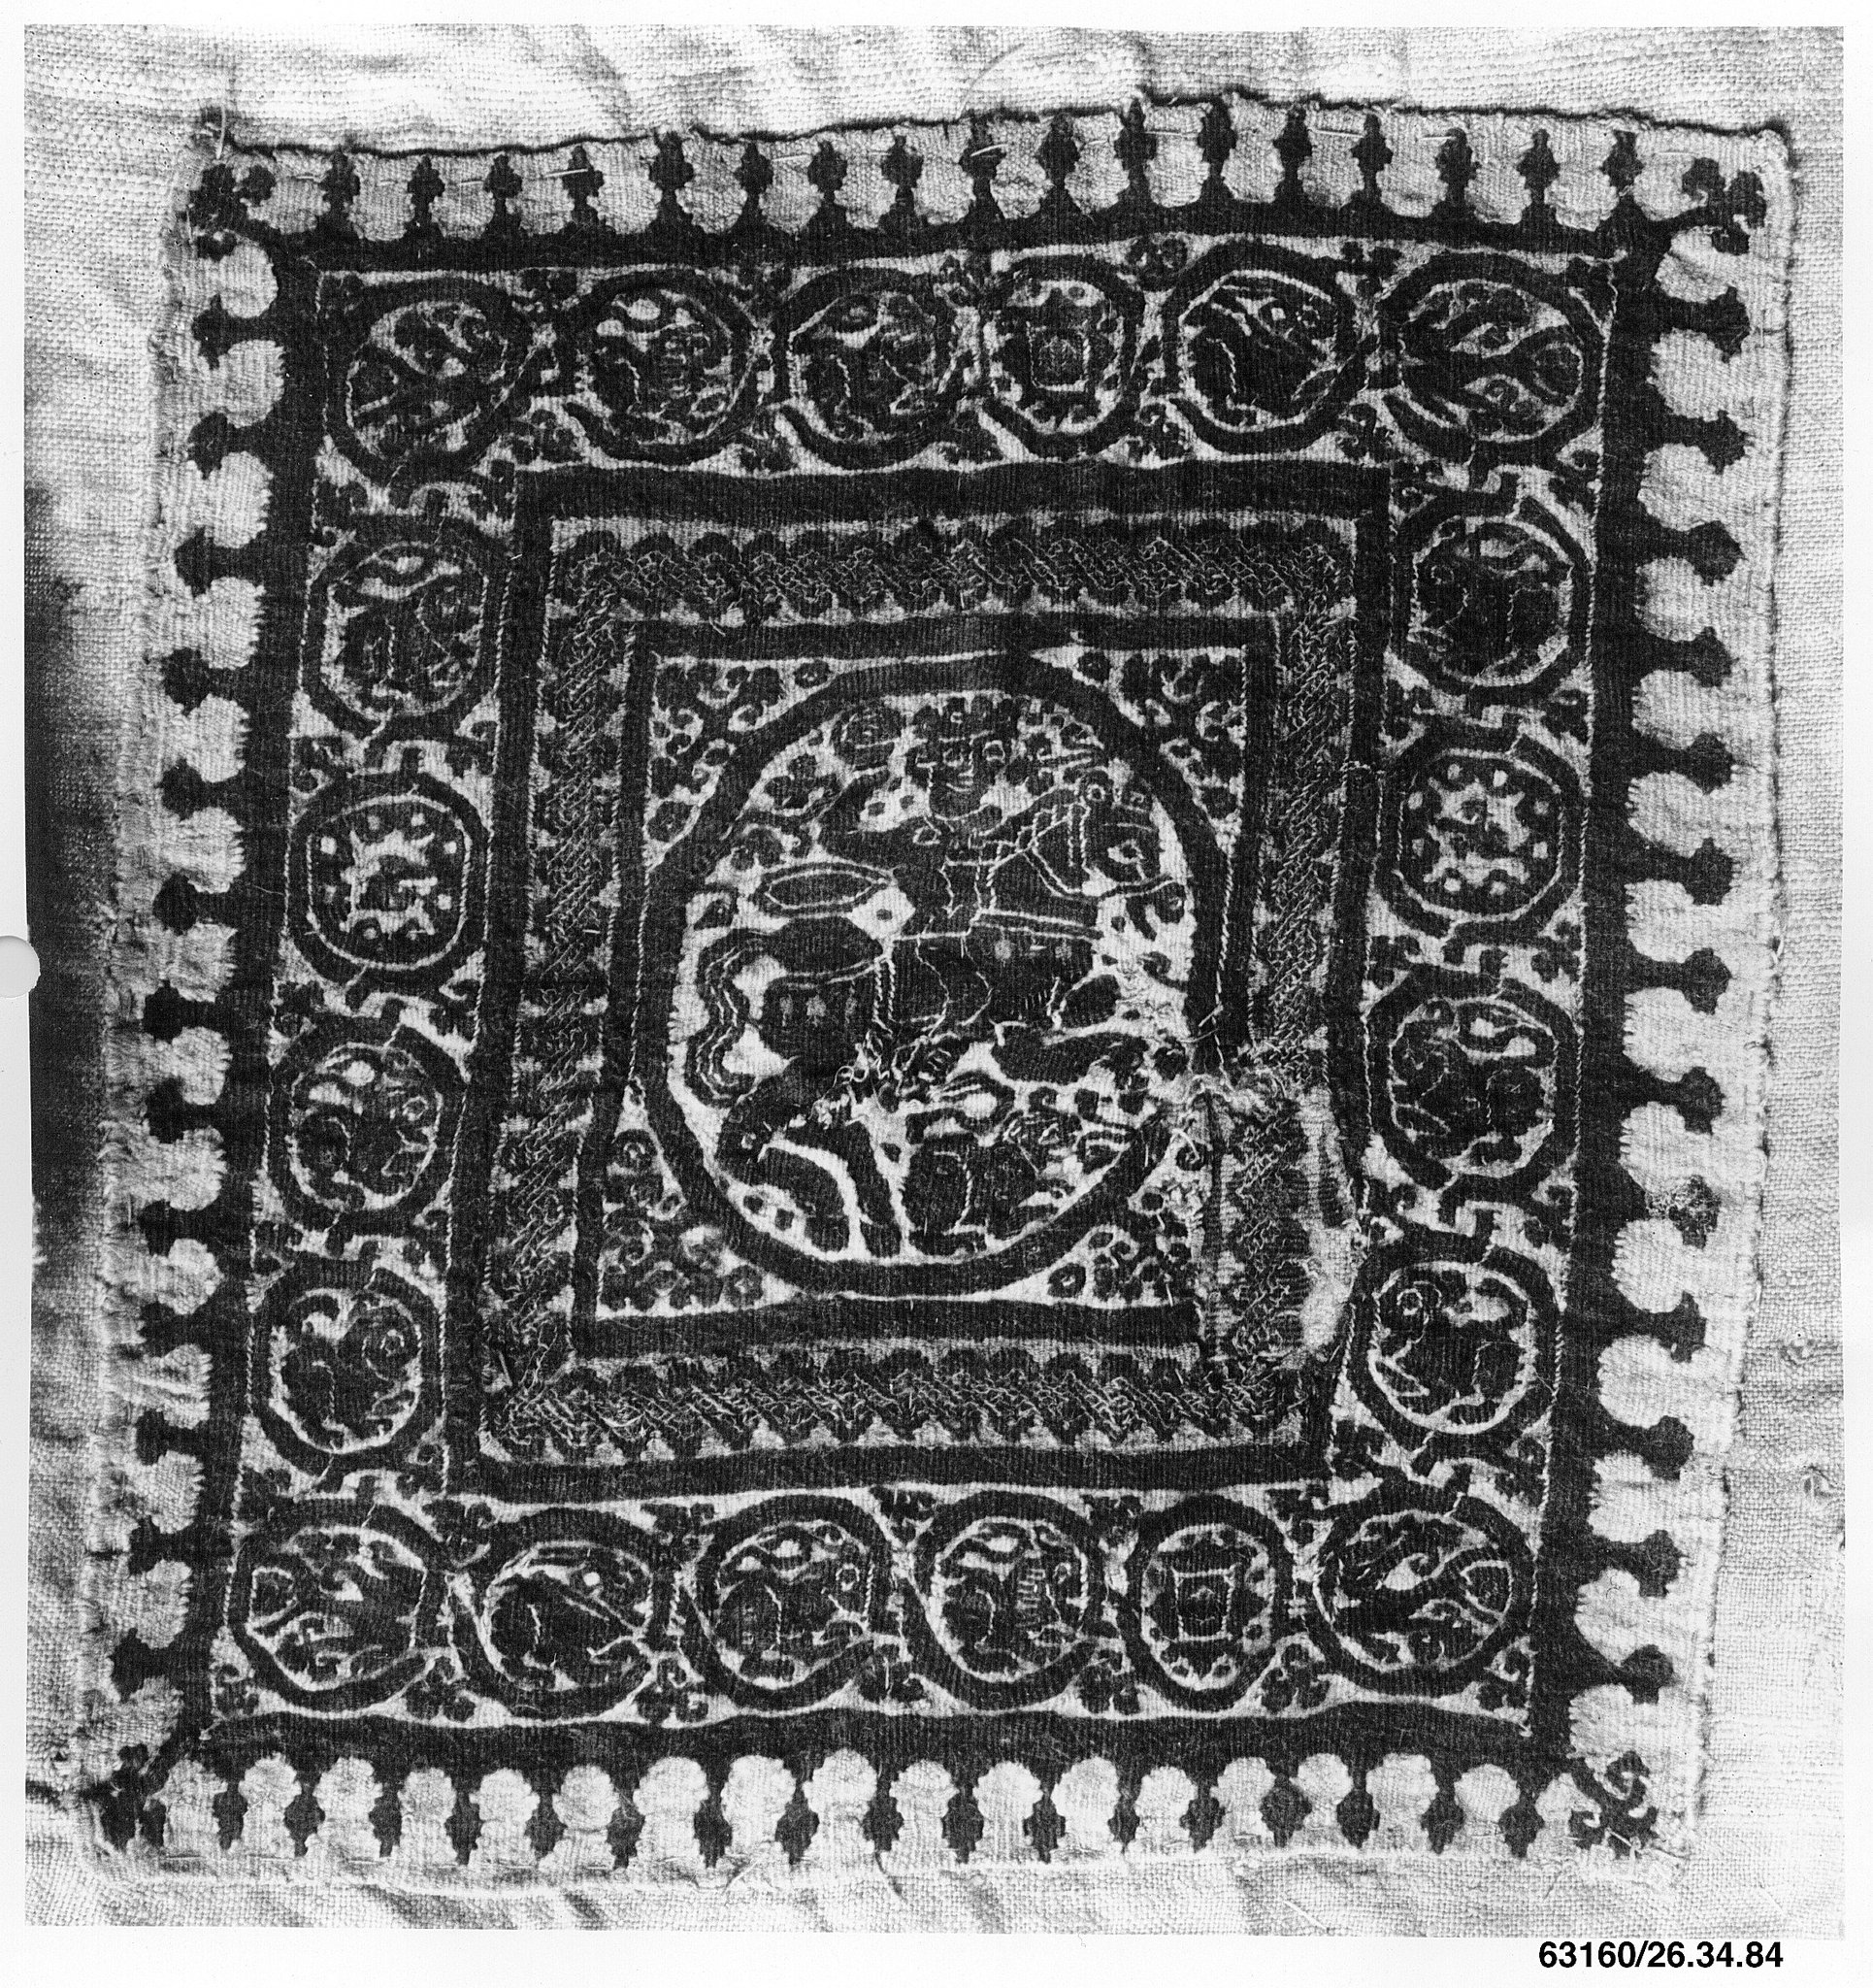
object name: panel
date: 301-400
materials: linen, wool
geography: egypt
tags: men,horses